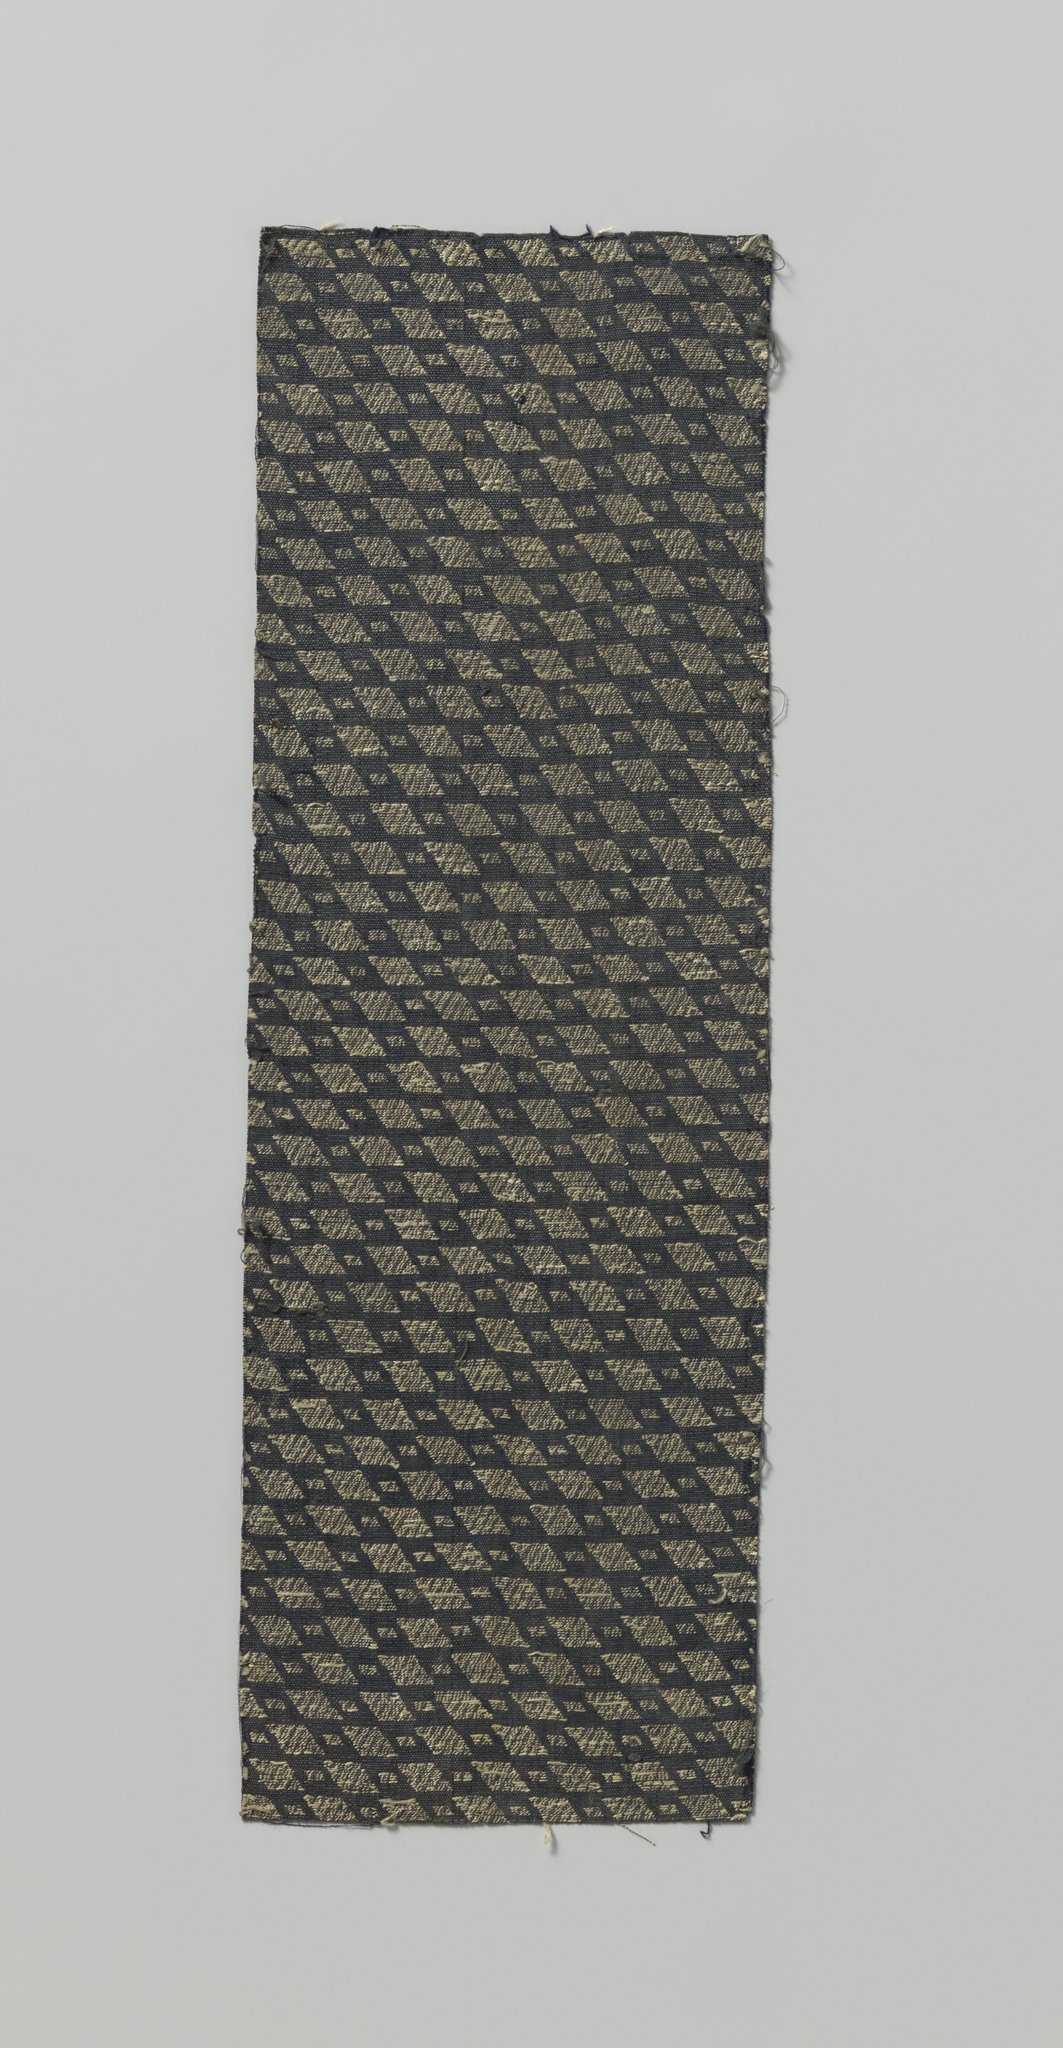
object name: fragment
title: Fragment oosterse textiel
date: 1800-1850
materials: cotton, silk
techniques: brocade, weave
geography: india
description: Een fragment van een weefsel. Ruitvormen in wit op een zwarte grond.